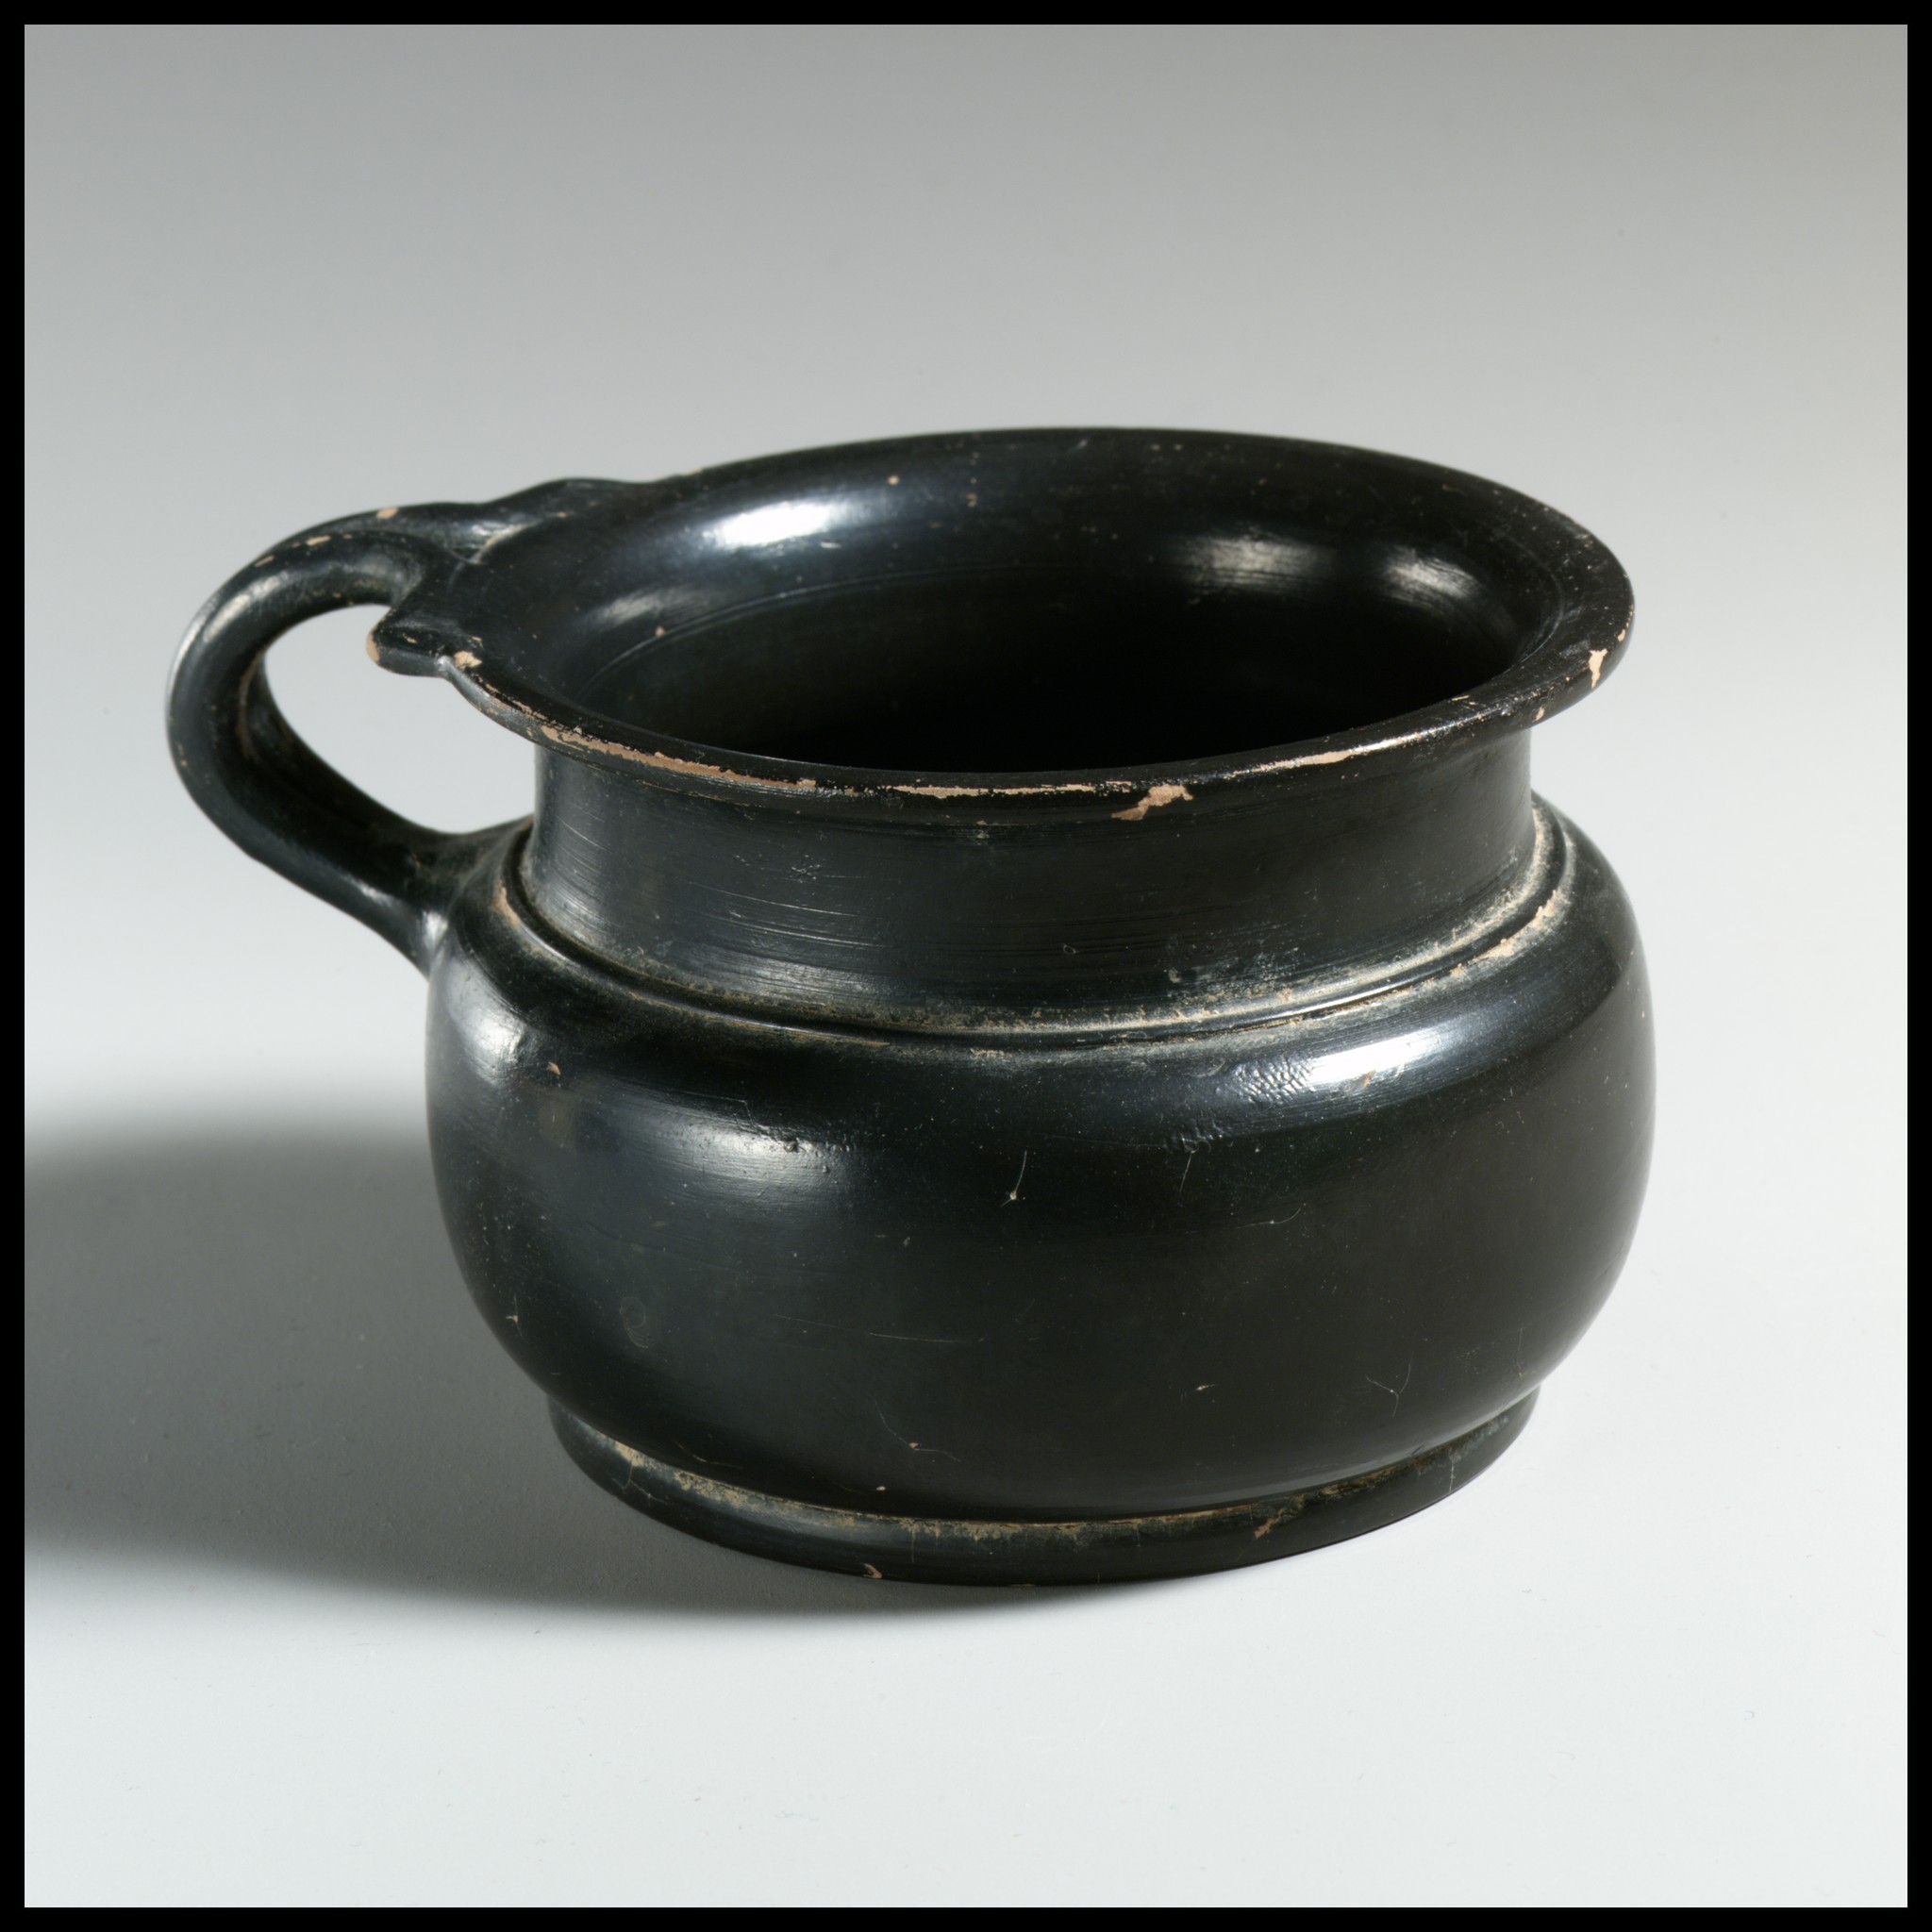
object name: mug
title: Terracotta mug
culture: greek, south italian, apulian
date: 434-368 BCE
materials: terracotta